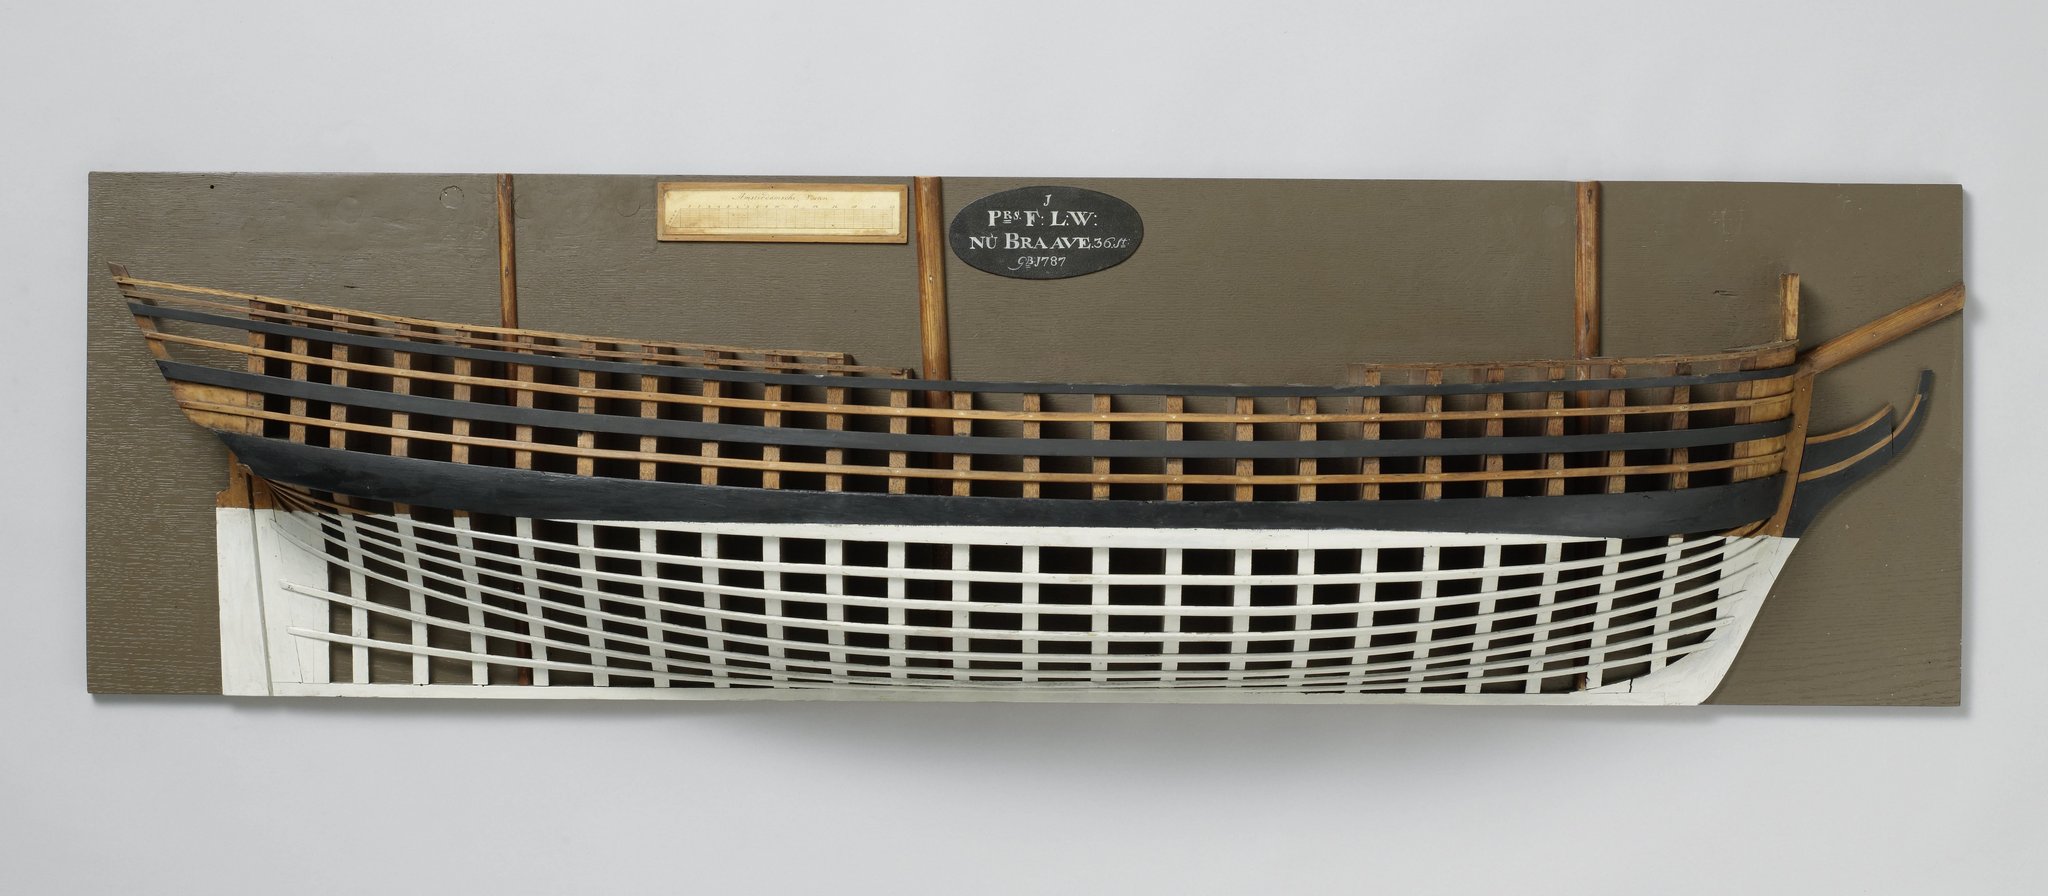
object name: half model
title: Half Model of a 36-Gun Frigate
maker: Anonymous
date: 1789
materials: wood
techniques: polychromy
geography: netherlands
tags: prinses frederica louisa wilhelmina (schip), brave (schip)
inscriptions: scale, top centre: paper scale in Amsterdam feet, inscription, top centre, on an oval black label: ‘1 / Prs. F:L:W: / NU BRAAVE. 36 St: / GB: 1787’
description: Halfmodel van een fregat van 36 stukken door P. Glavimans, ca. 1789. Halfmodellen kunnen dienen als hulpmiddel bij de bouw van schepen, als een soort driedimensionale ontwerptekening. Pieter Glavimans (1755-1820) was scheepsbouwer op de Rotterdamse marine-werf. Toen in 1795 de regionale Admiraliteiten werden vervangen door een gecentraliseerde marine, werd Glavimans aangesteld als constructeur-generaal. Het gebruik van halfmodellen werd door hem op landelijke schaal geïntroduceerd.